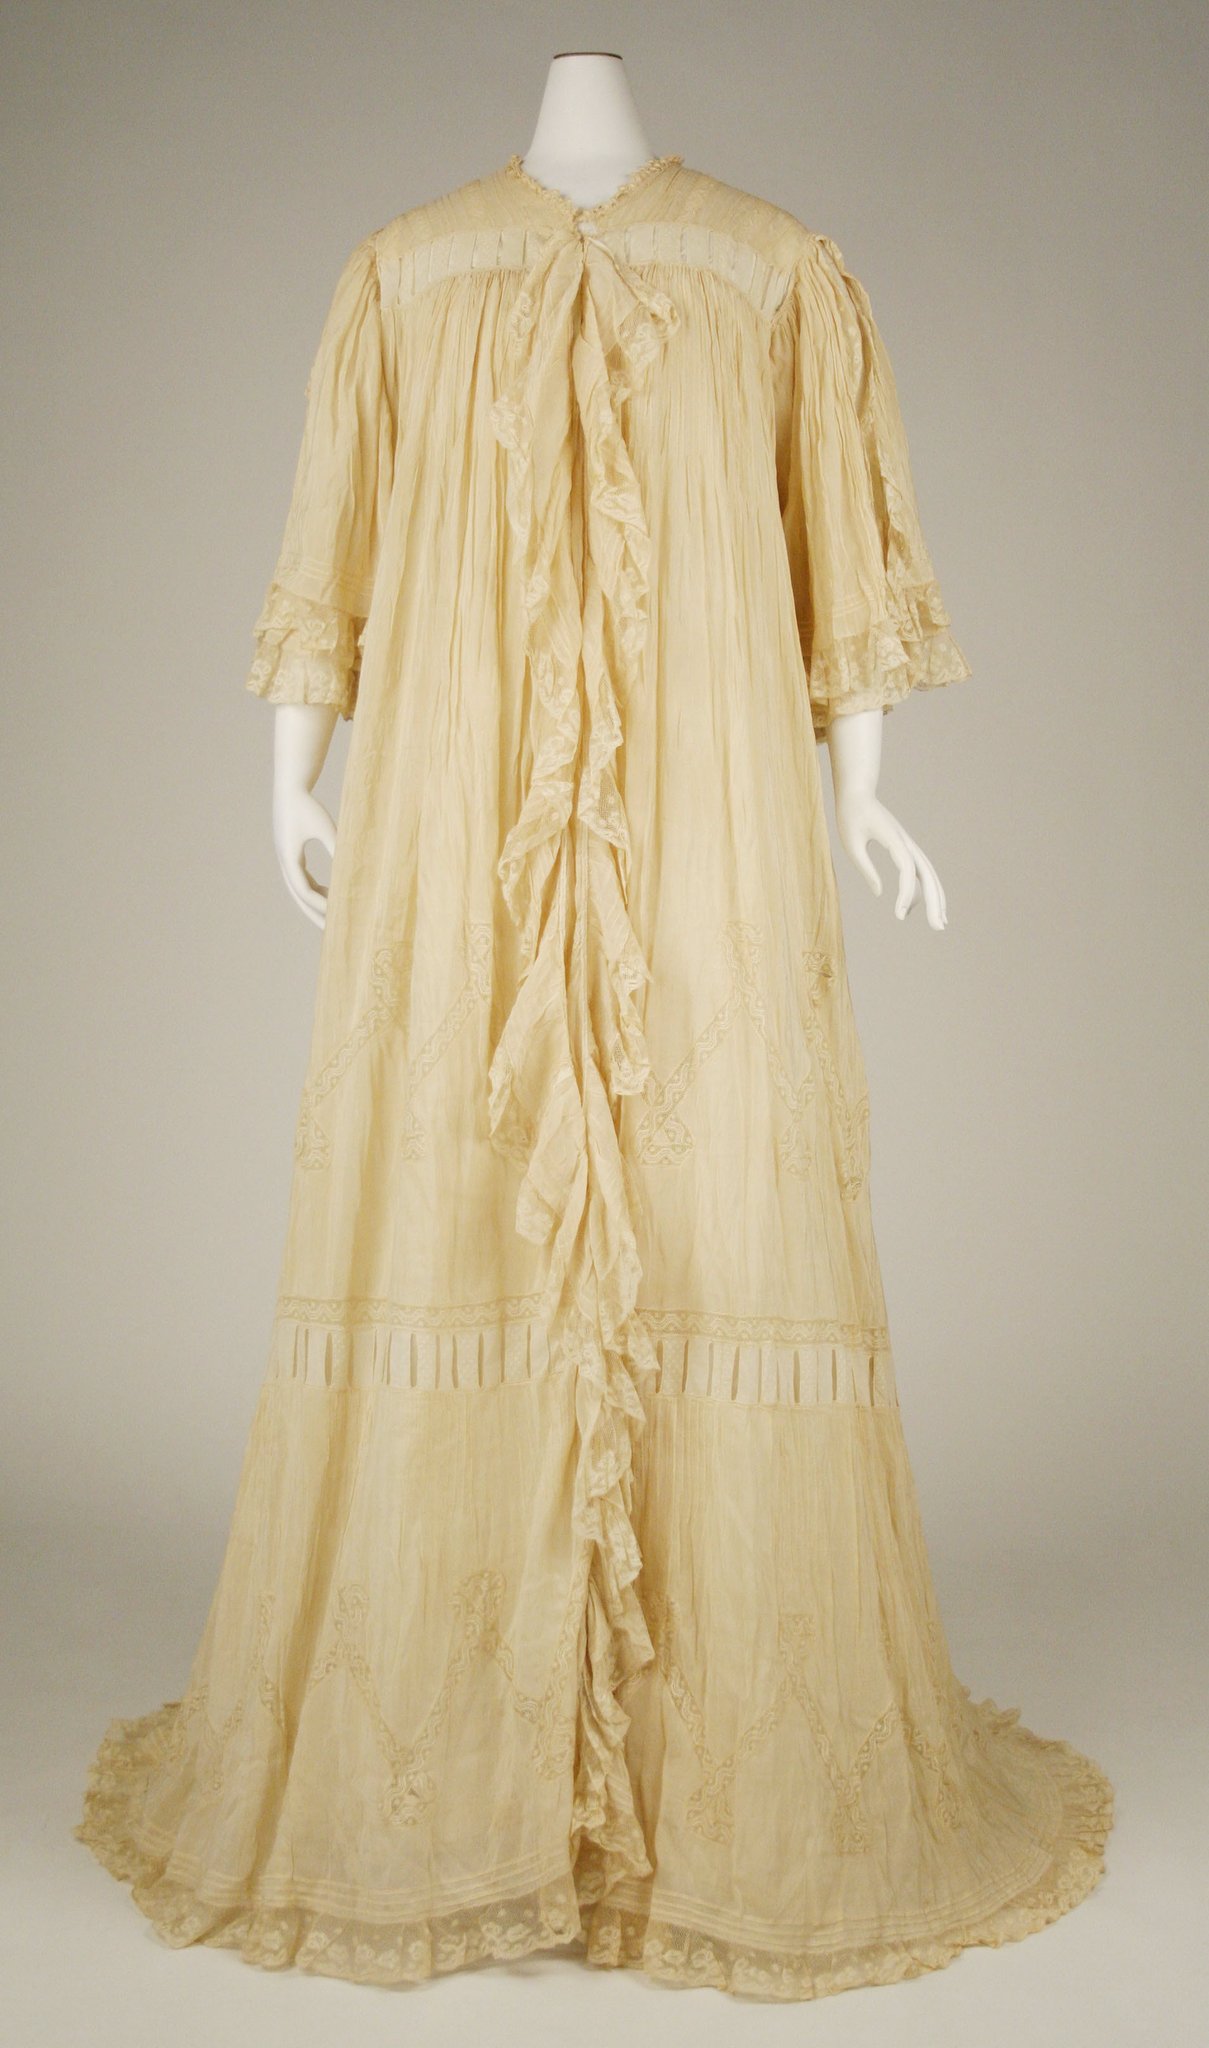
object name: negligée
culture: american or european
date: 1900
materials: cotton, silk